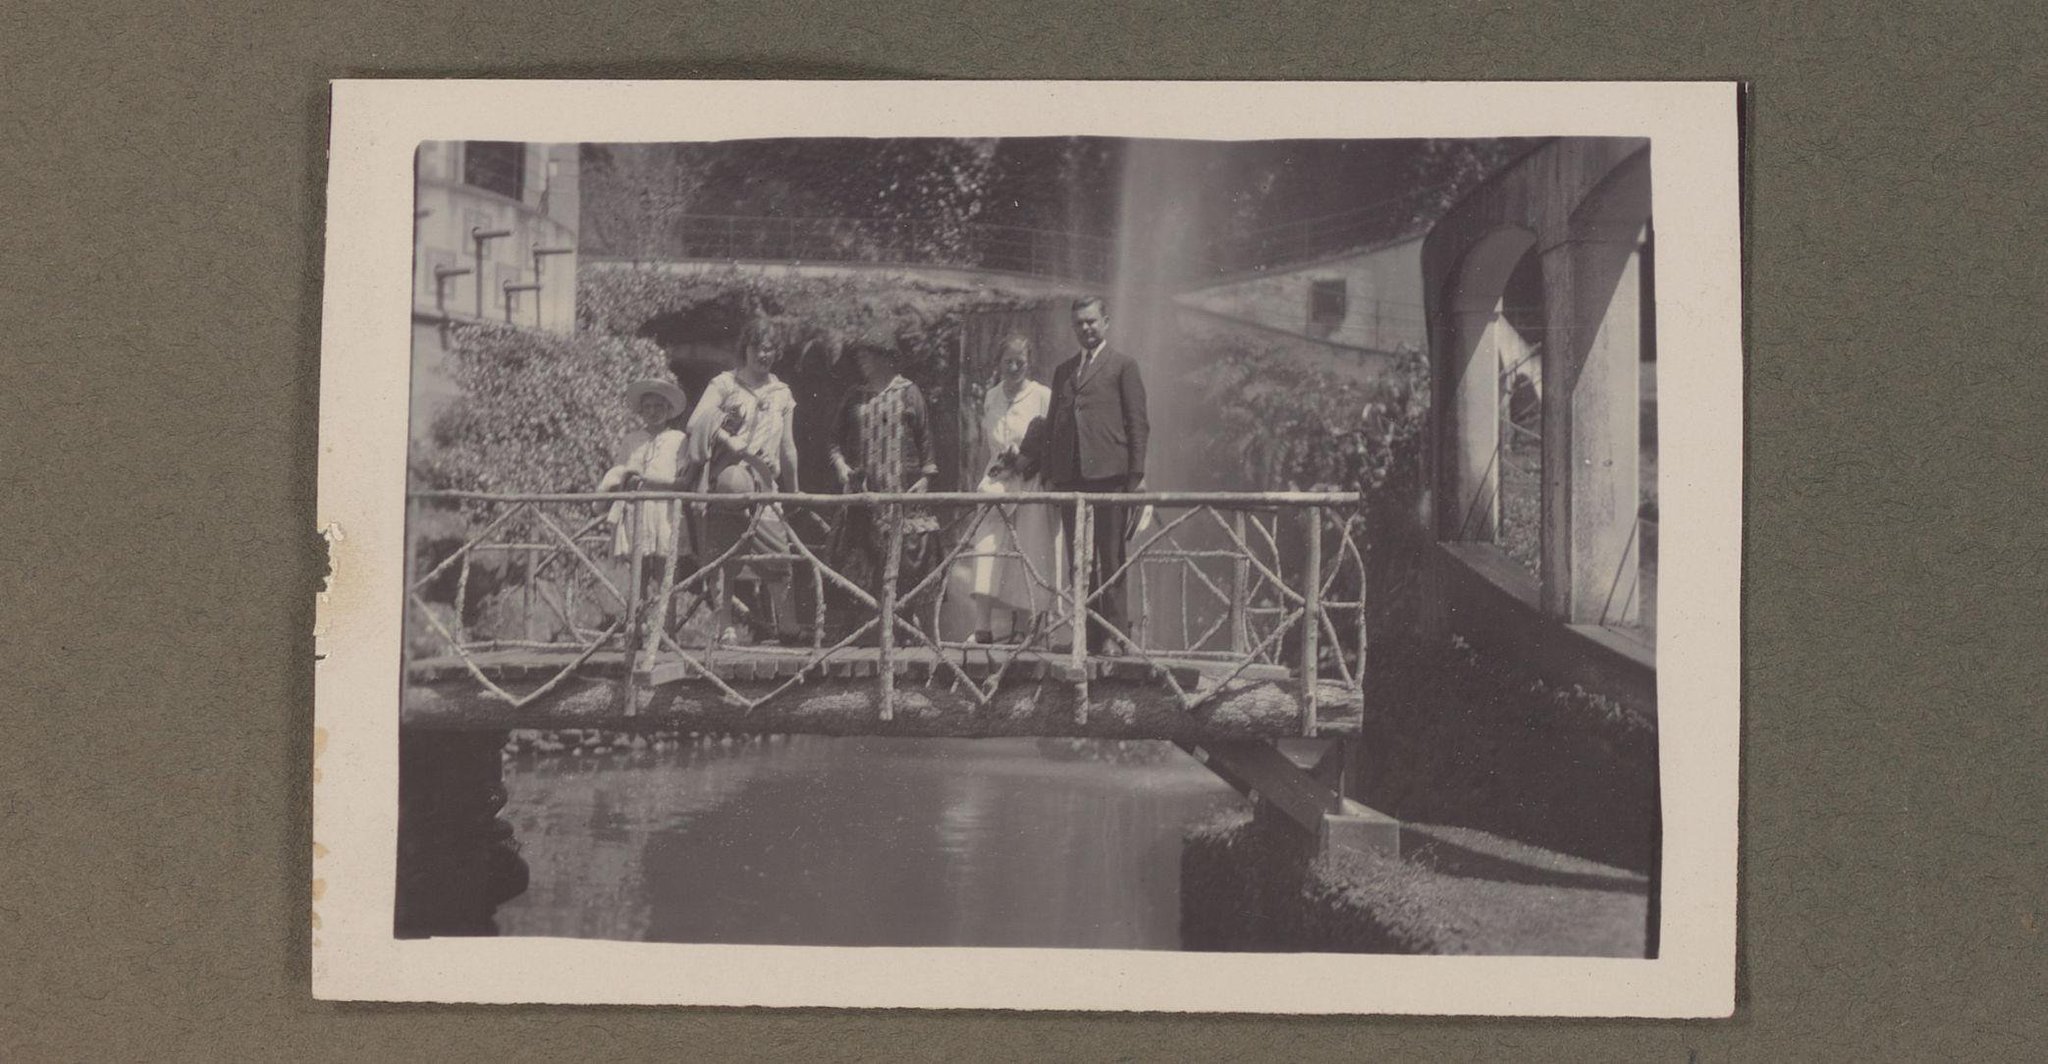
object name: photograph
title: Bezoek aan Madeira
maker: Anonymous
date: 1925-1927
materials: photographic support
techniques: photography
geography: suriname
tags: jetten, familie, moengo, madeira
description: Bezoek aan Madeira, poserend op een brug. Foto op een bladzijde van een los albumblad. Onderdeel van het ensemble met foto's van de familie van ingenieur Jetten in de mijnbouwstad Moengo in Suriname.